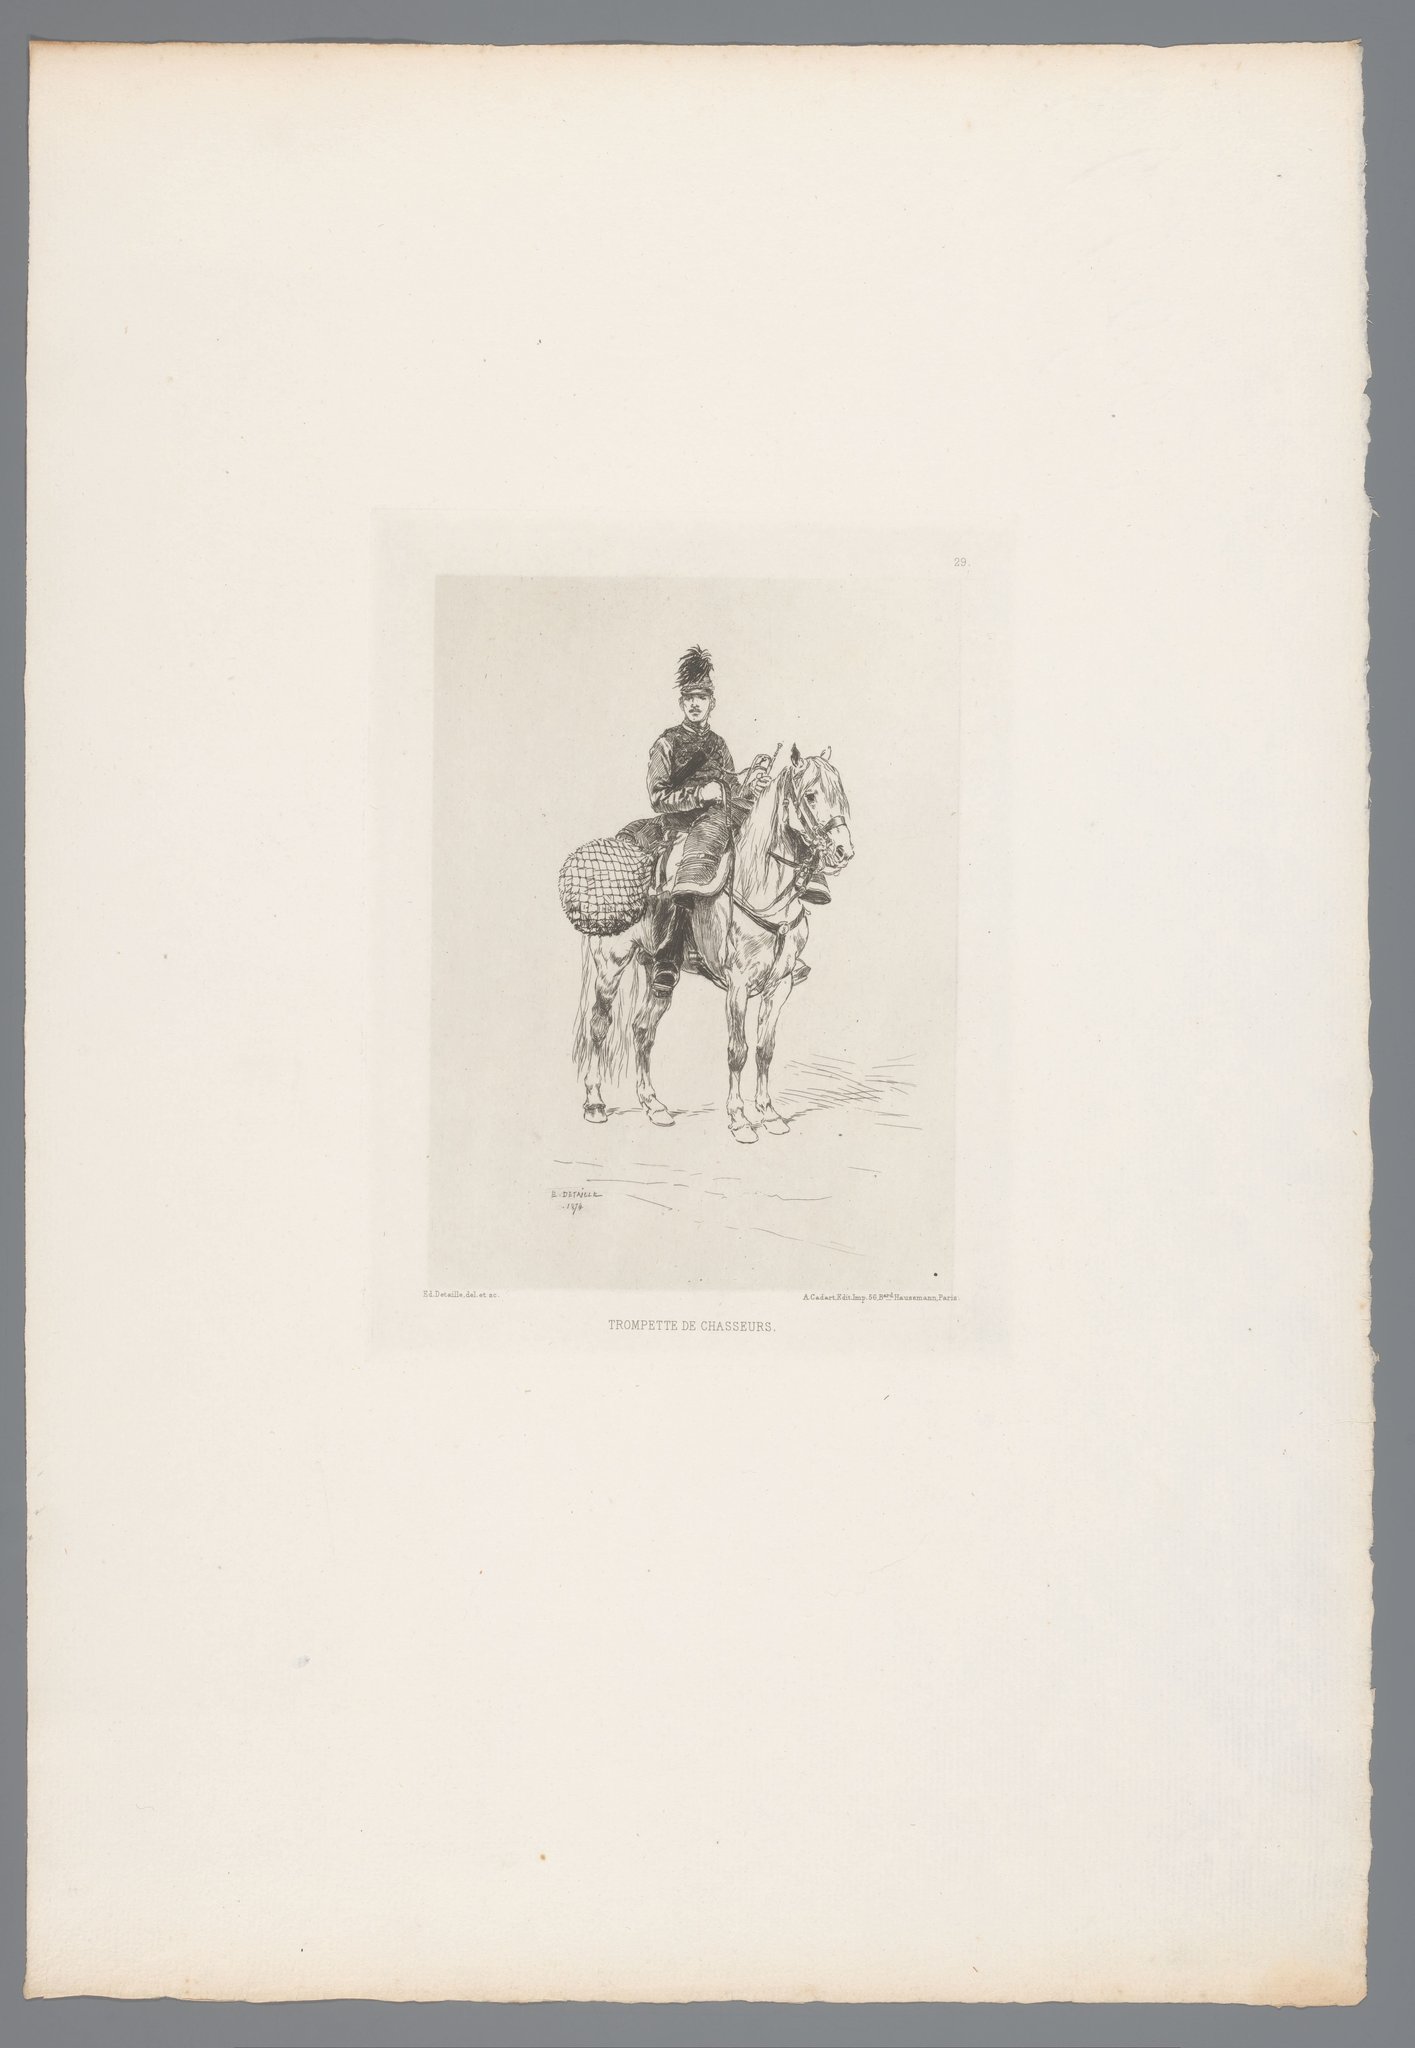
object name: print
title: Cavalerist met trompet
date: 1875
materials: paper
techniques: drypoint, etching, intaglio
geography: paris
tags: military music, animals used in the army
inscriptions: collector's mark: ‘AFE v S’, collector's mark: Lugt 2228, collector's mark: Lugt 2760